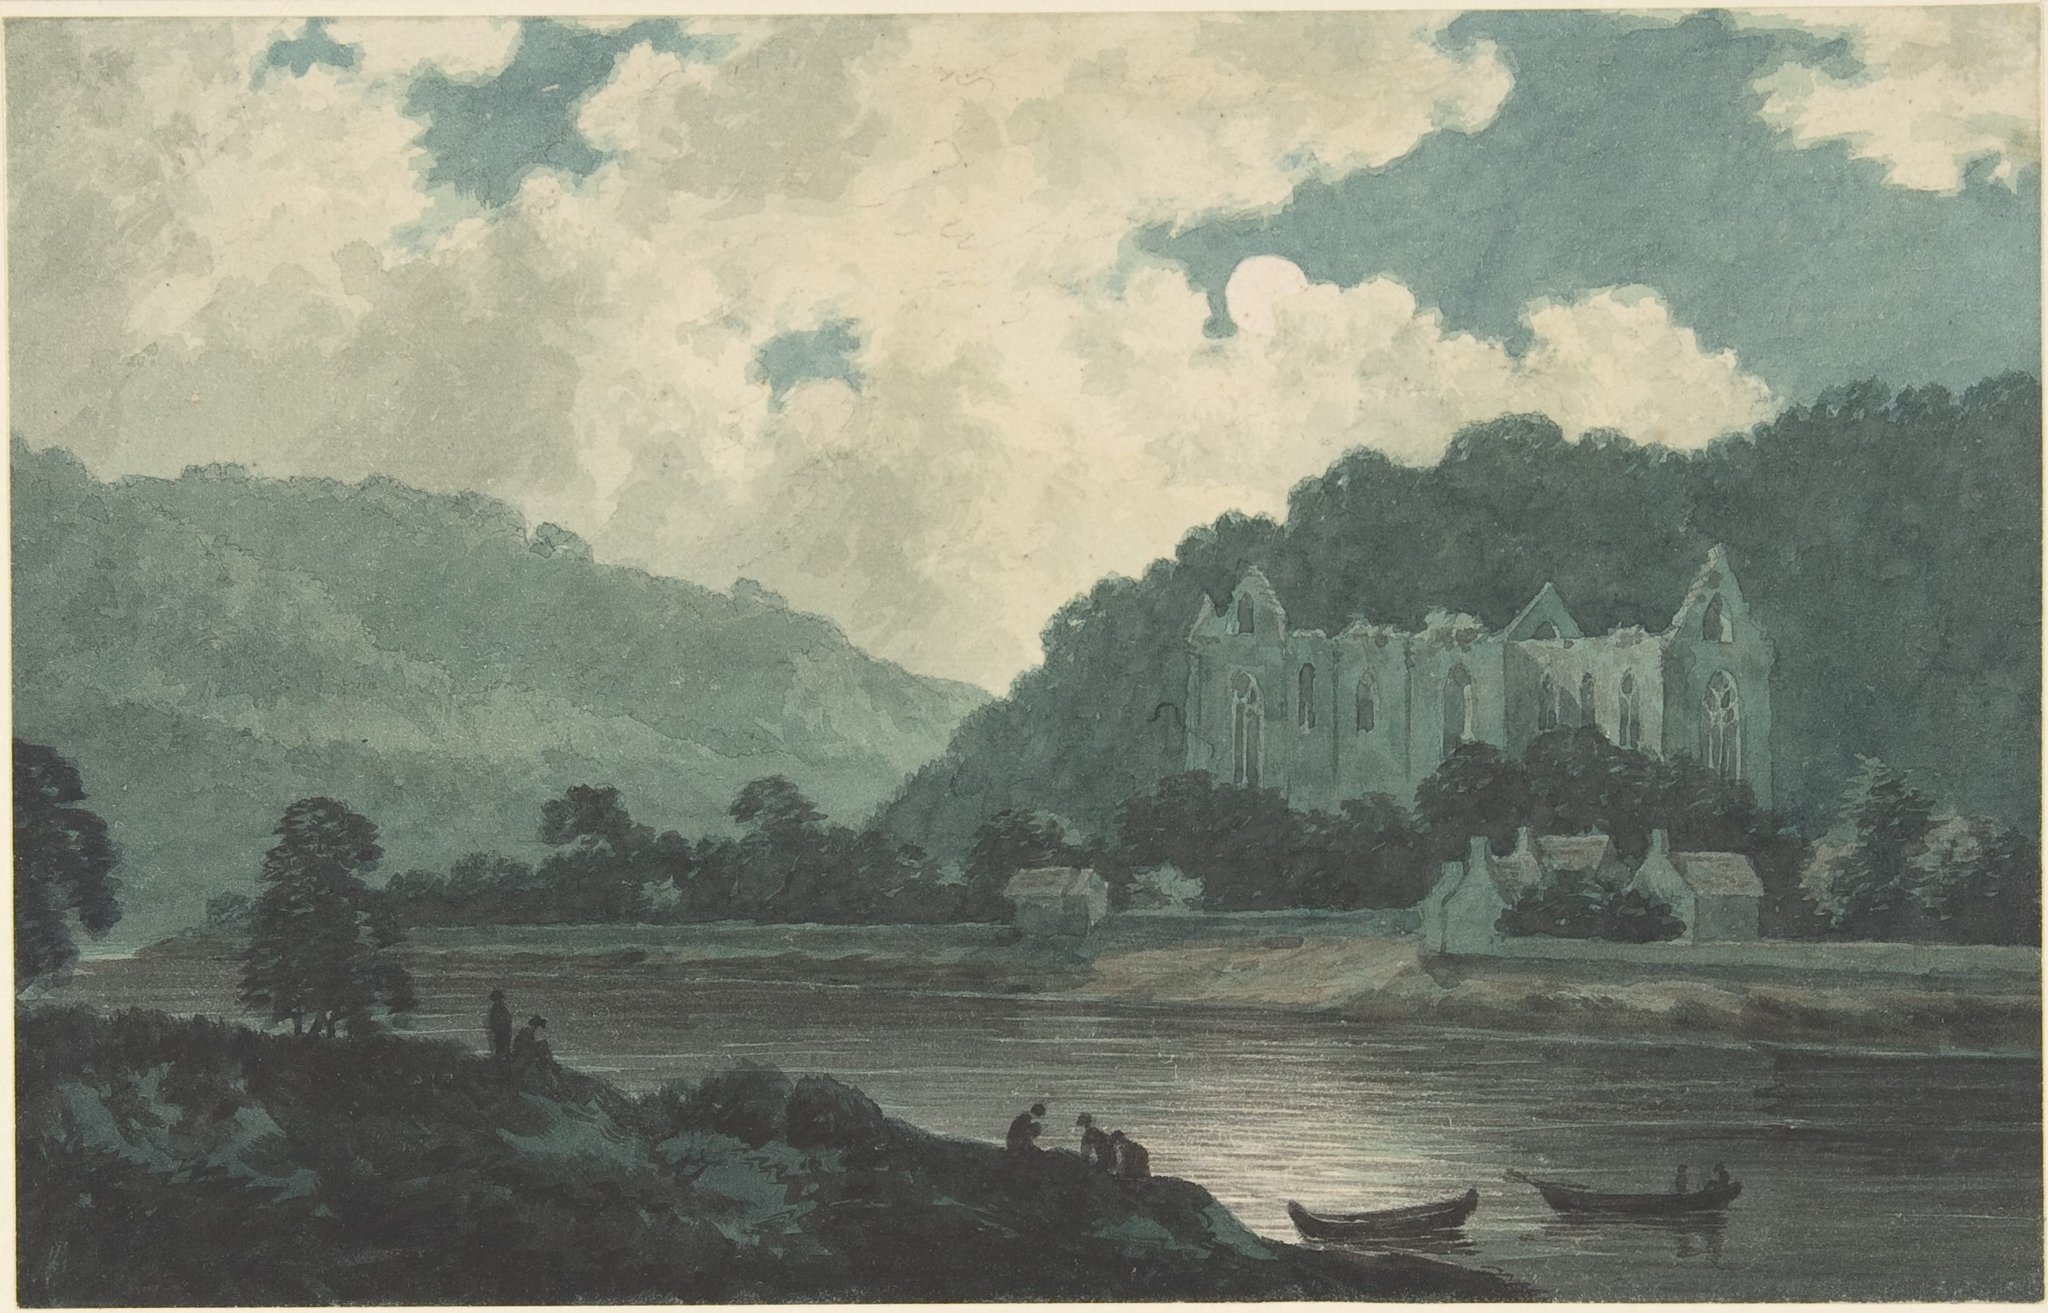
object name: drawing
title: Tintern Abbey by moonlight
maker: john "warwick" smith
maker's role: artist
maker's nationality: british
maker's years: 1749-1831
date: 1789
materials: graphite, watercolor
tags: human figures,abbeys,ruins,rivers,landscapes